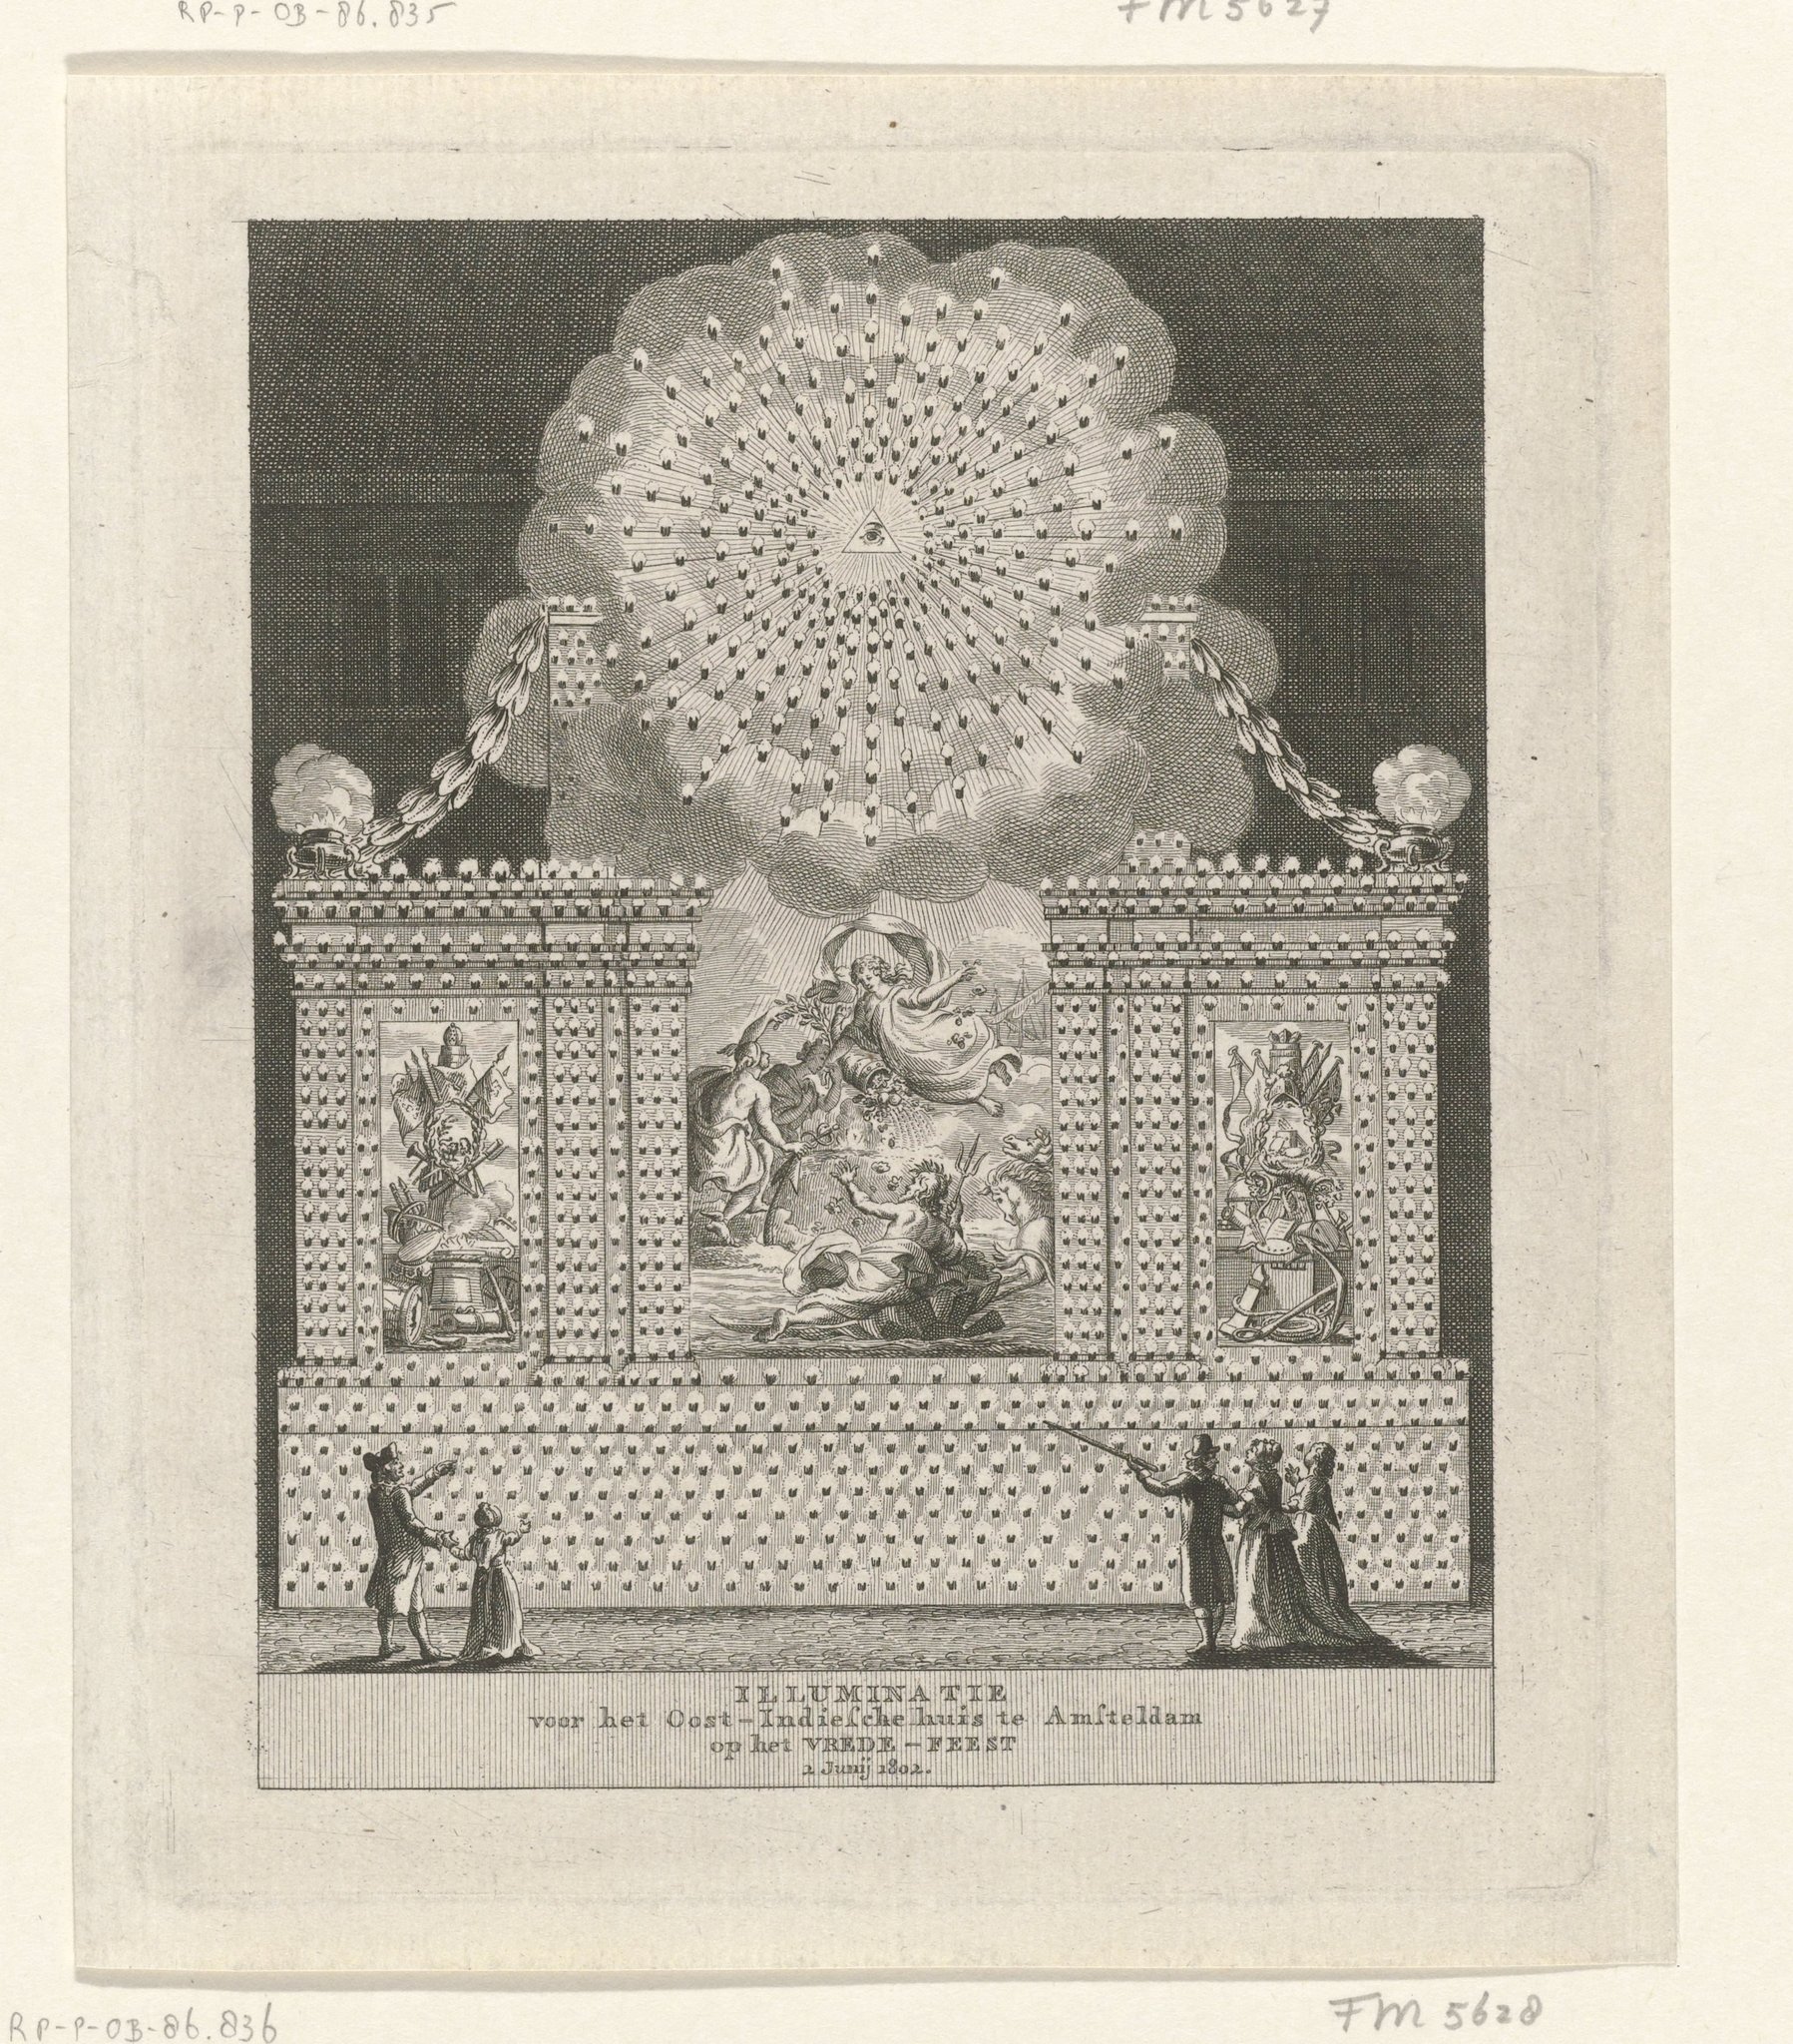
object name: print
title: Illuminatie voor het Oost-Indiesche huis te Amsteldam op het Vrede-Feest 2 Junij 1802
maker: Anonymous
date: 1802-1803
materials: paper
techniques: engraving, etching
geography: netherlands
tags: bonfire, fire-works (+ illumination, fire-works ~ festive activities)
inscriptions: collector's mark: Lugt 2228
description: Illuminatie opgericht voor het Oost-Indisch Huis te Amsterdam, bij de feestelijke viering van de Vrede van Amiens op 2 juni 1802. Bij de prent behoort een tekstblad. Afzonderlijke afdruk uit de Nederlandsche Mercurius van 1802.